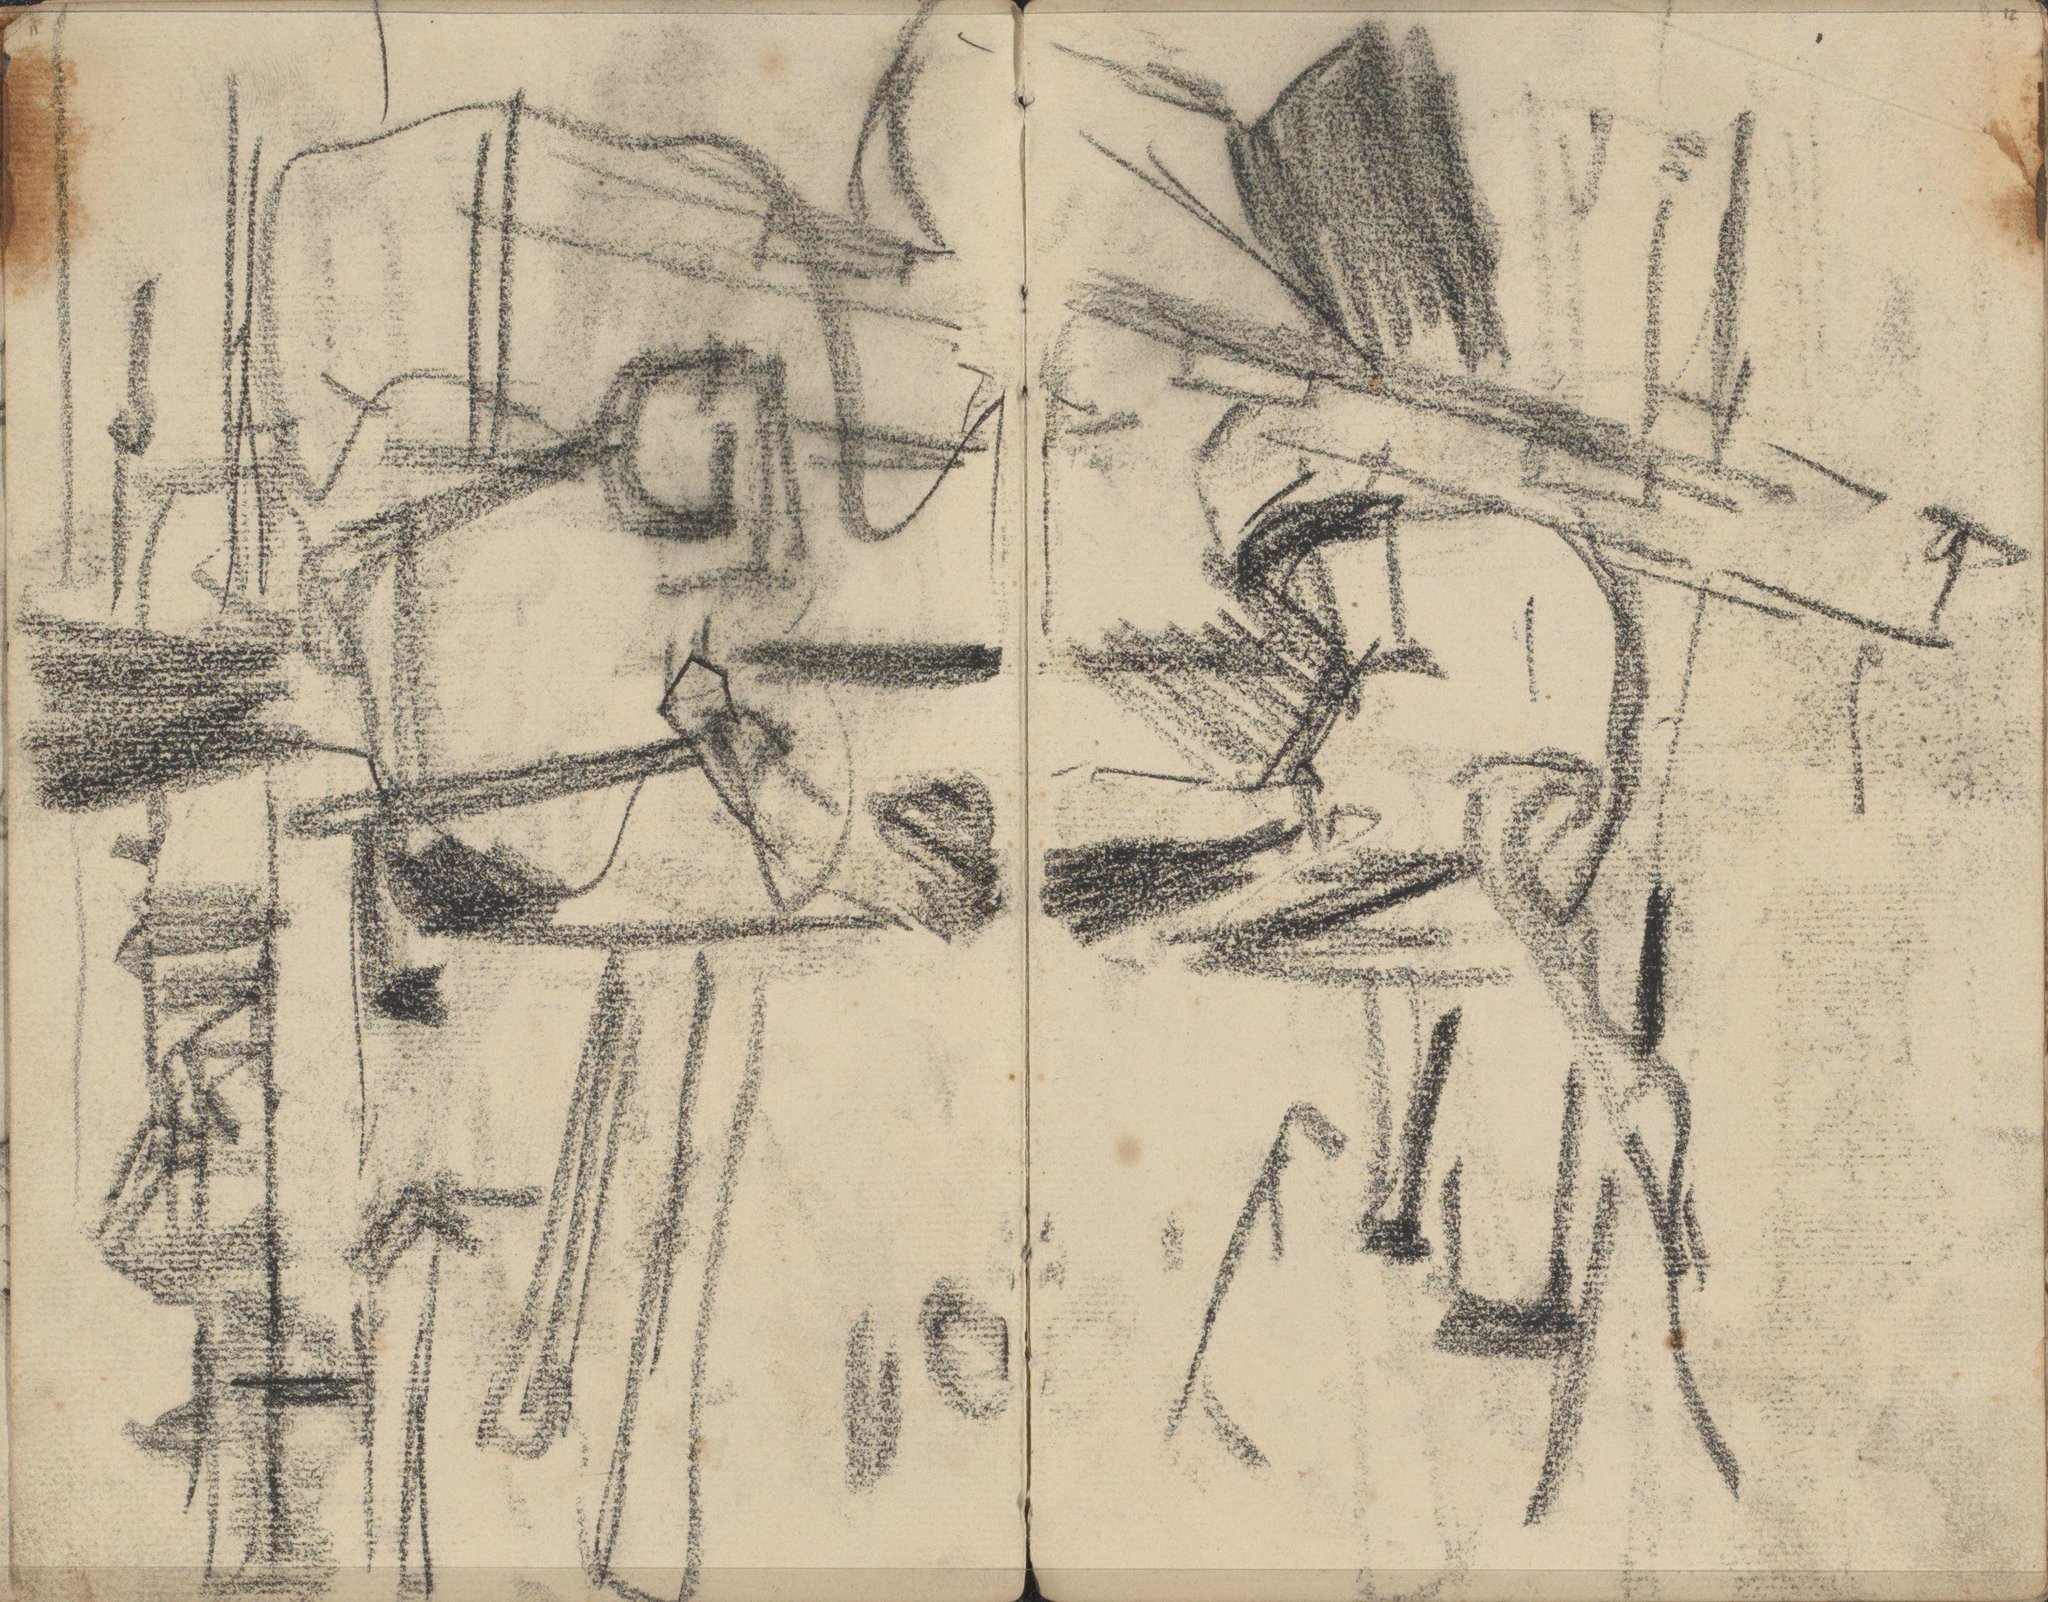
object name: sketchbook leaf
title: Studie, mogelijk van een bouwterrein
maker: george hendrik breitner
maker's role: draughtsman, painter, print maker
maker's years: 1857-1923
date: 1887-1891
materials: chalk, paper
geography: amsterdam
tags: building-site, civic architecture; edifices; dwellings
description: Pagina 11 en pagina 12 uit een schetsboek met 17 bladen.